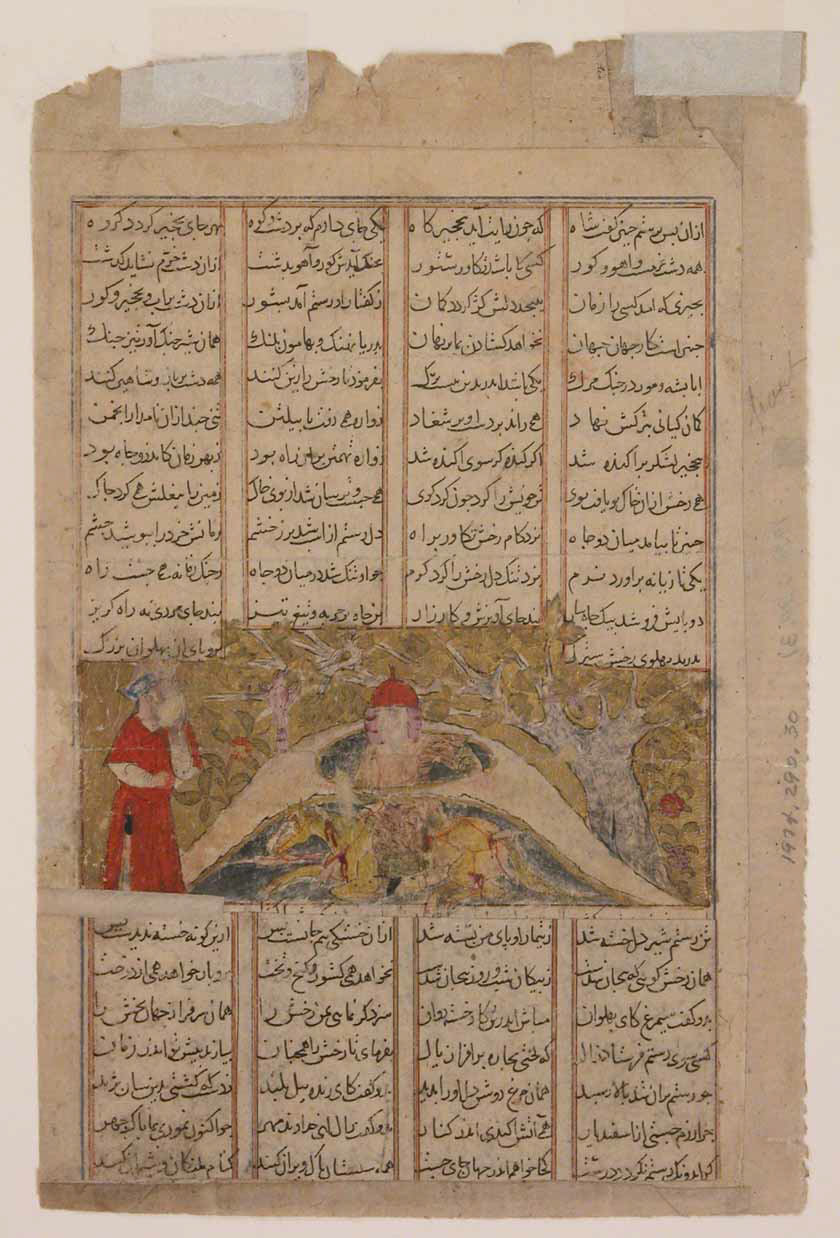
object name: folio fro290. 30m an illustrated manuscript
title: "Rustam Falls in the Spear-Lined Pit", Folio from a Shahnama (Book of Kings)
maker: abu'l qasim firdausi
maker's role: author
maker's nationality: iranian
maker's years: 935-1020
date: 1330-1340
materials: gold, ink, paper, silver, watercolor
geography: iran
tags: animals,men